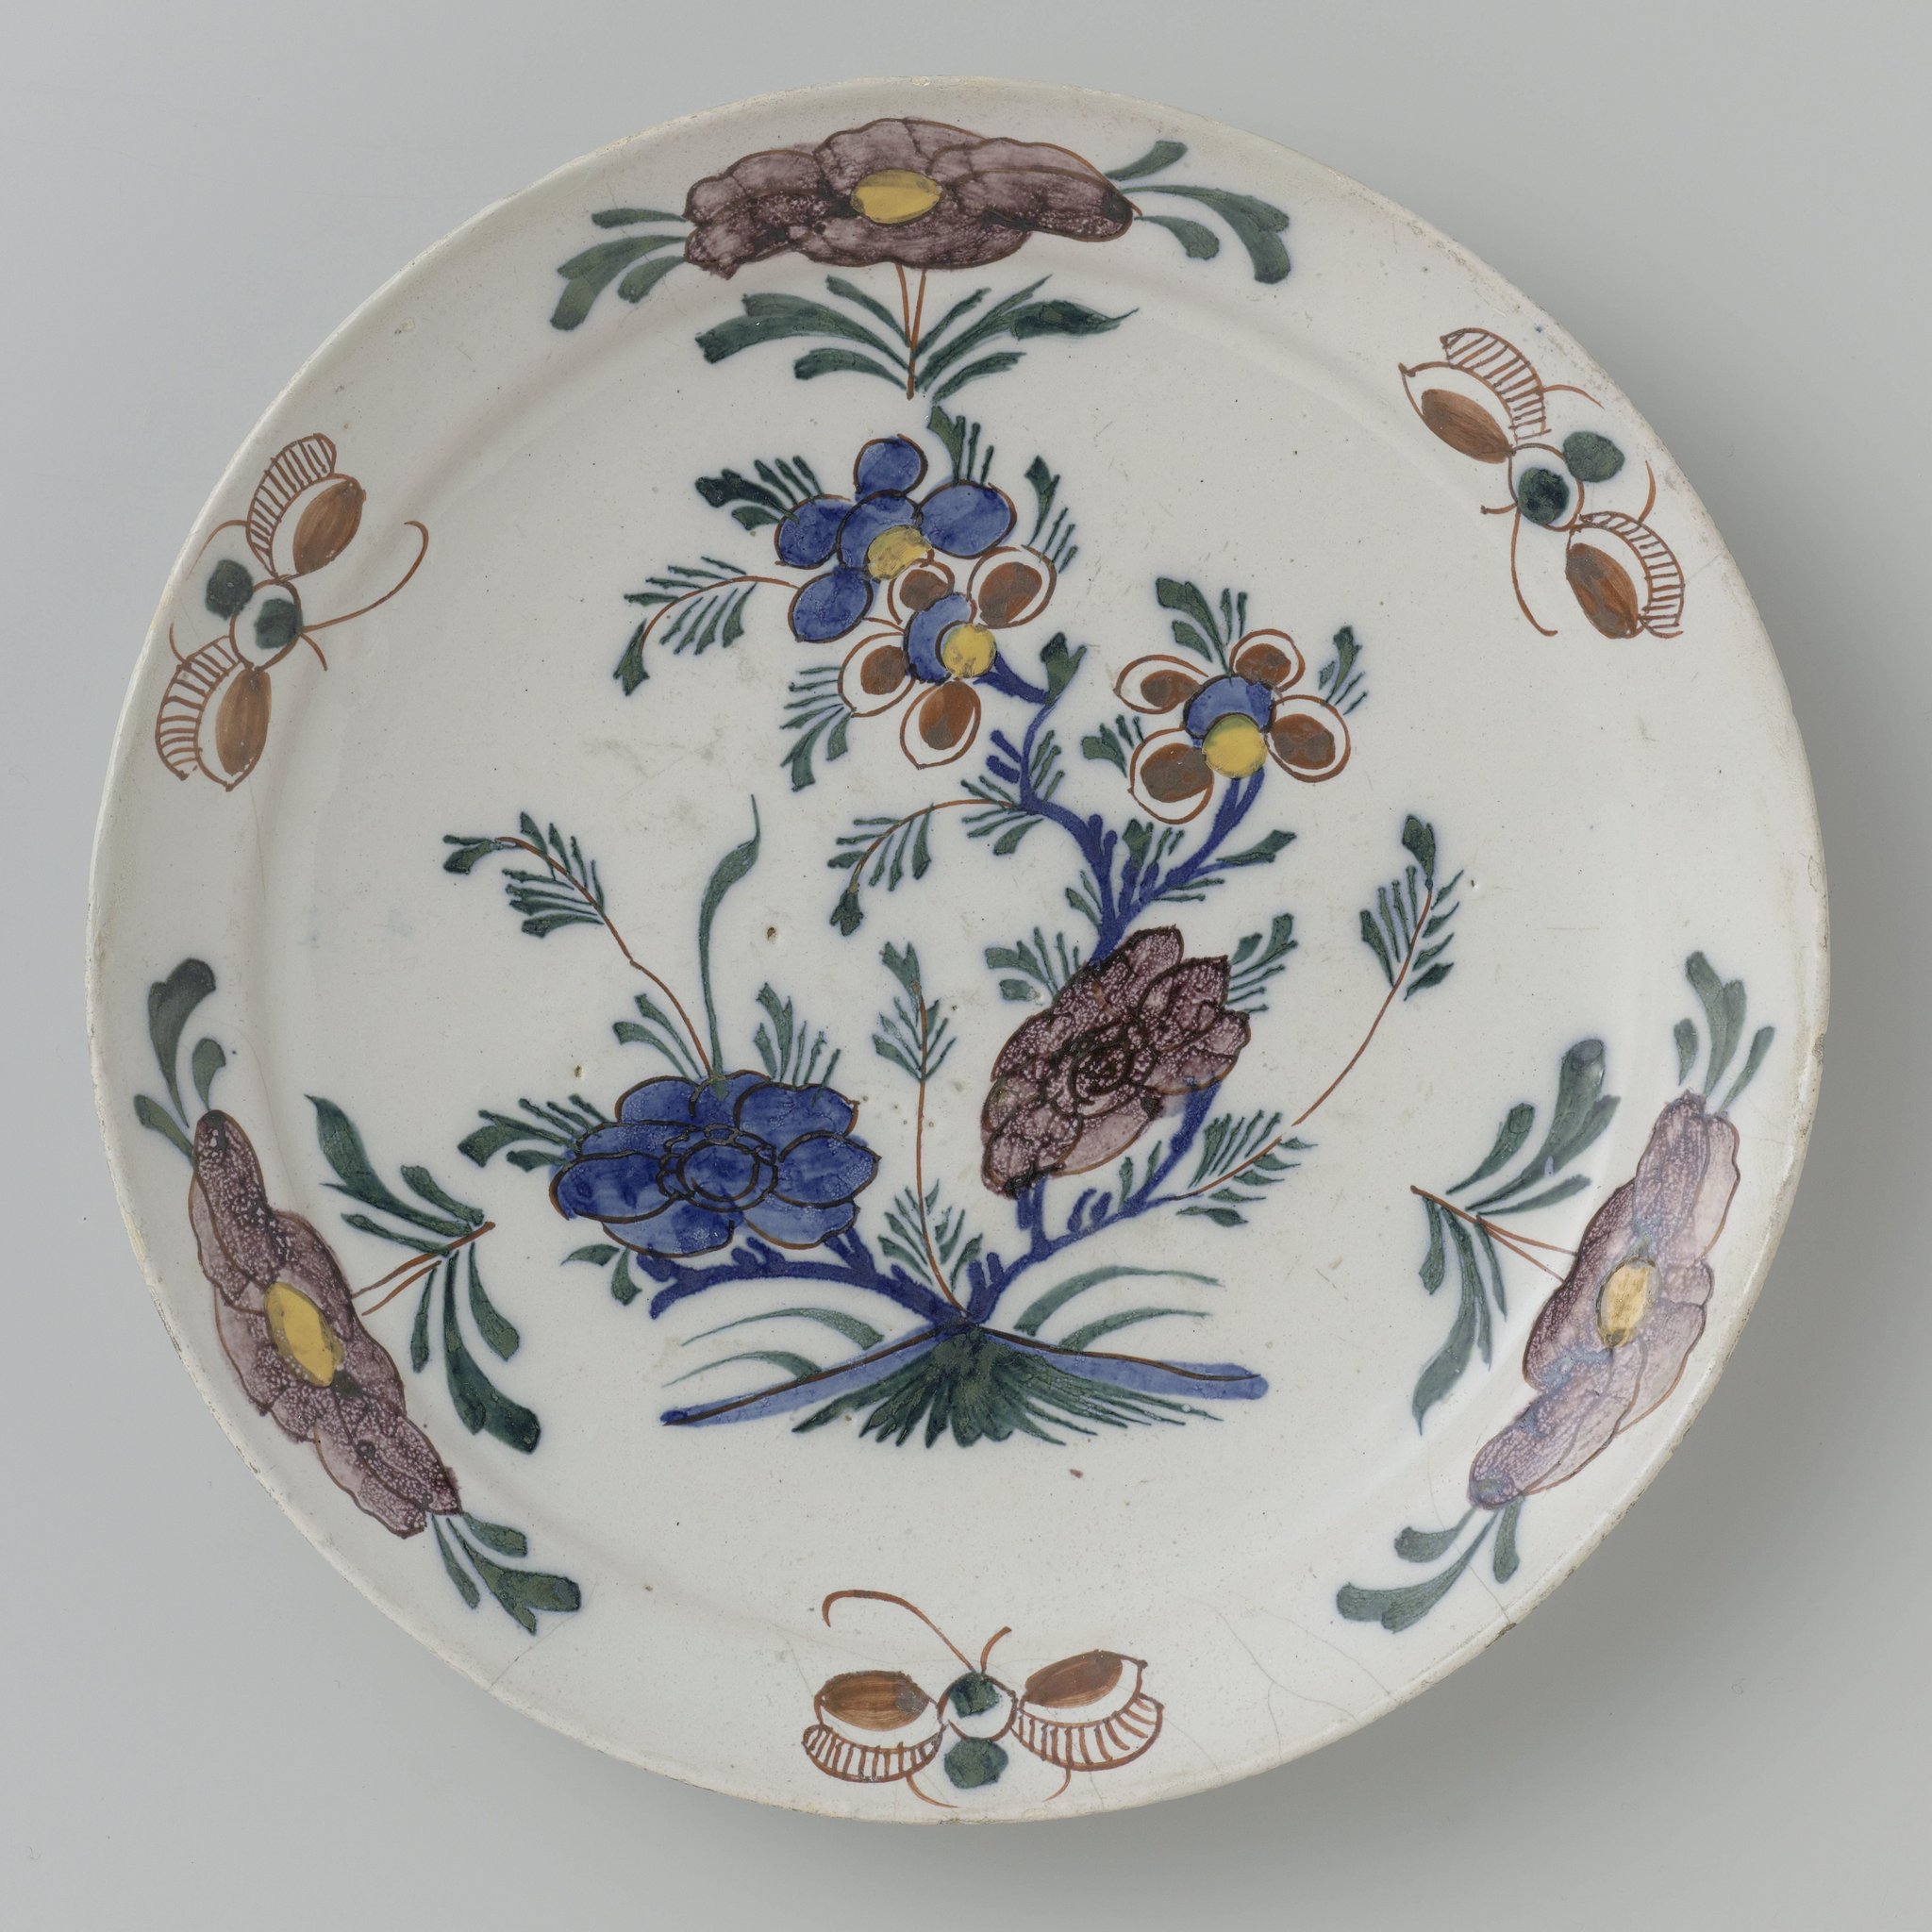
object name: plate dish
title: Bord van veelkleurig beschilderd faience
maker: Anonymous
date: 1750-1790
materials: earthenware, glaze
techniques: painted, polychromy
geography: delft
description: Rond bord van beschilderde faience, met op het plat en op de rand planten en bloemen in de kleuren bruin, blauw, geel en groen.